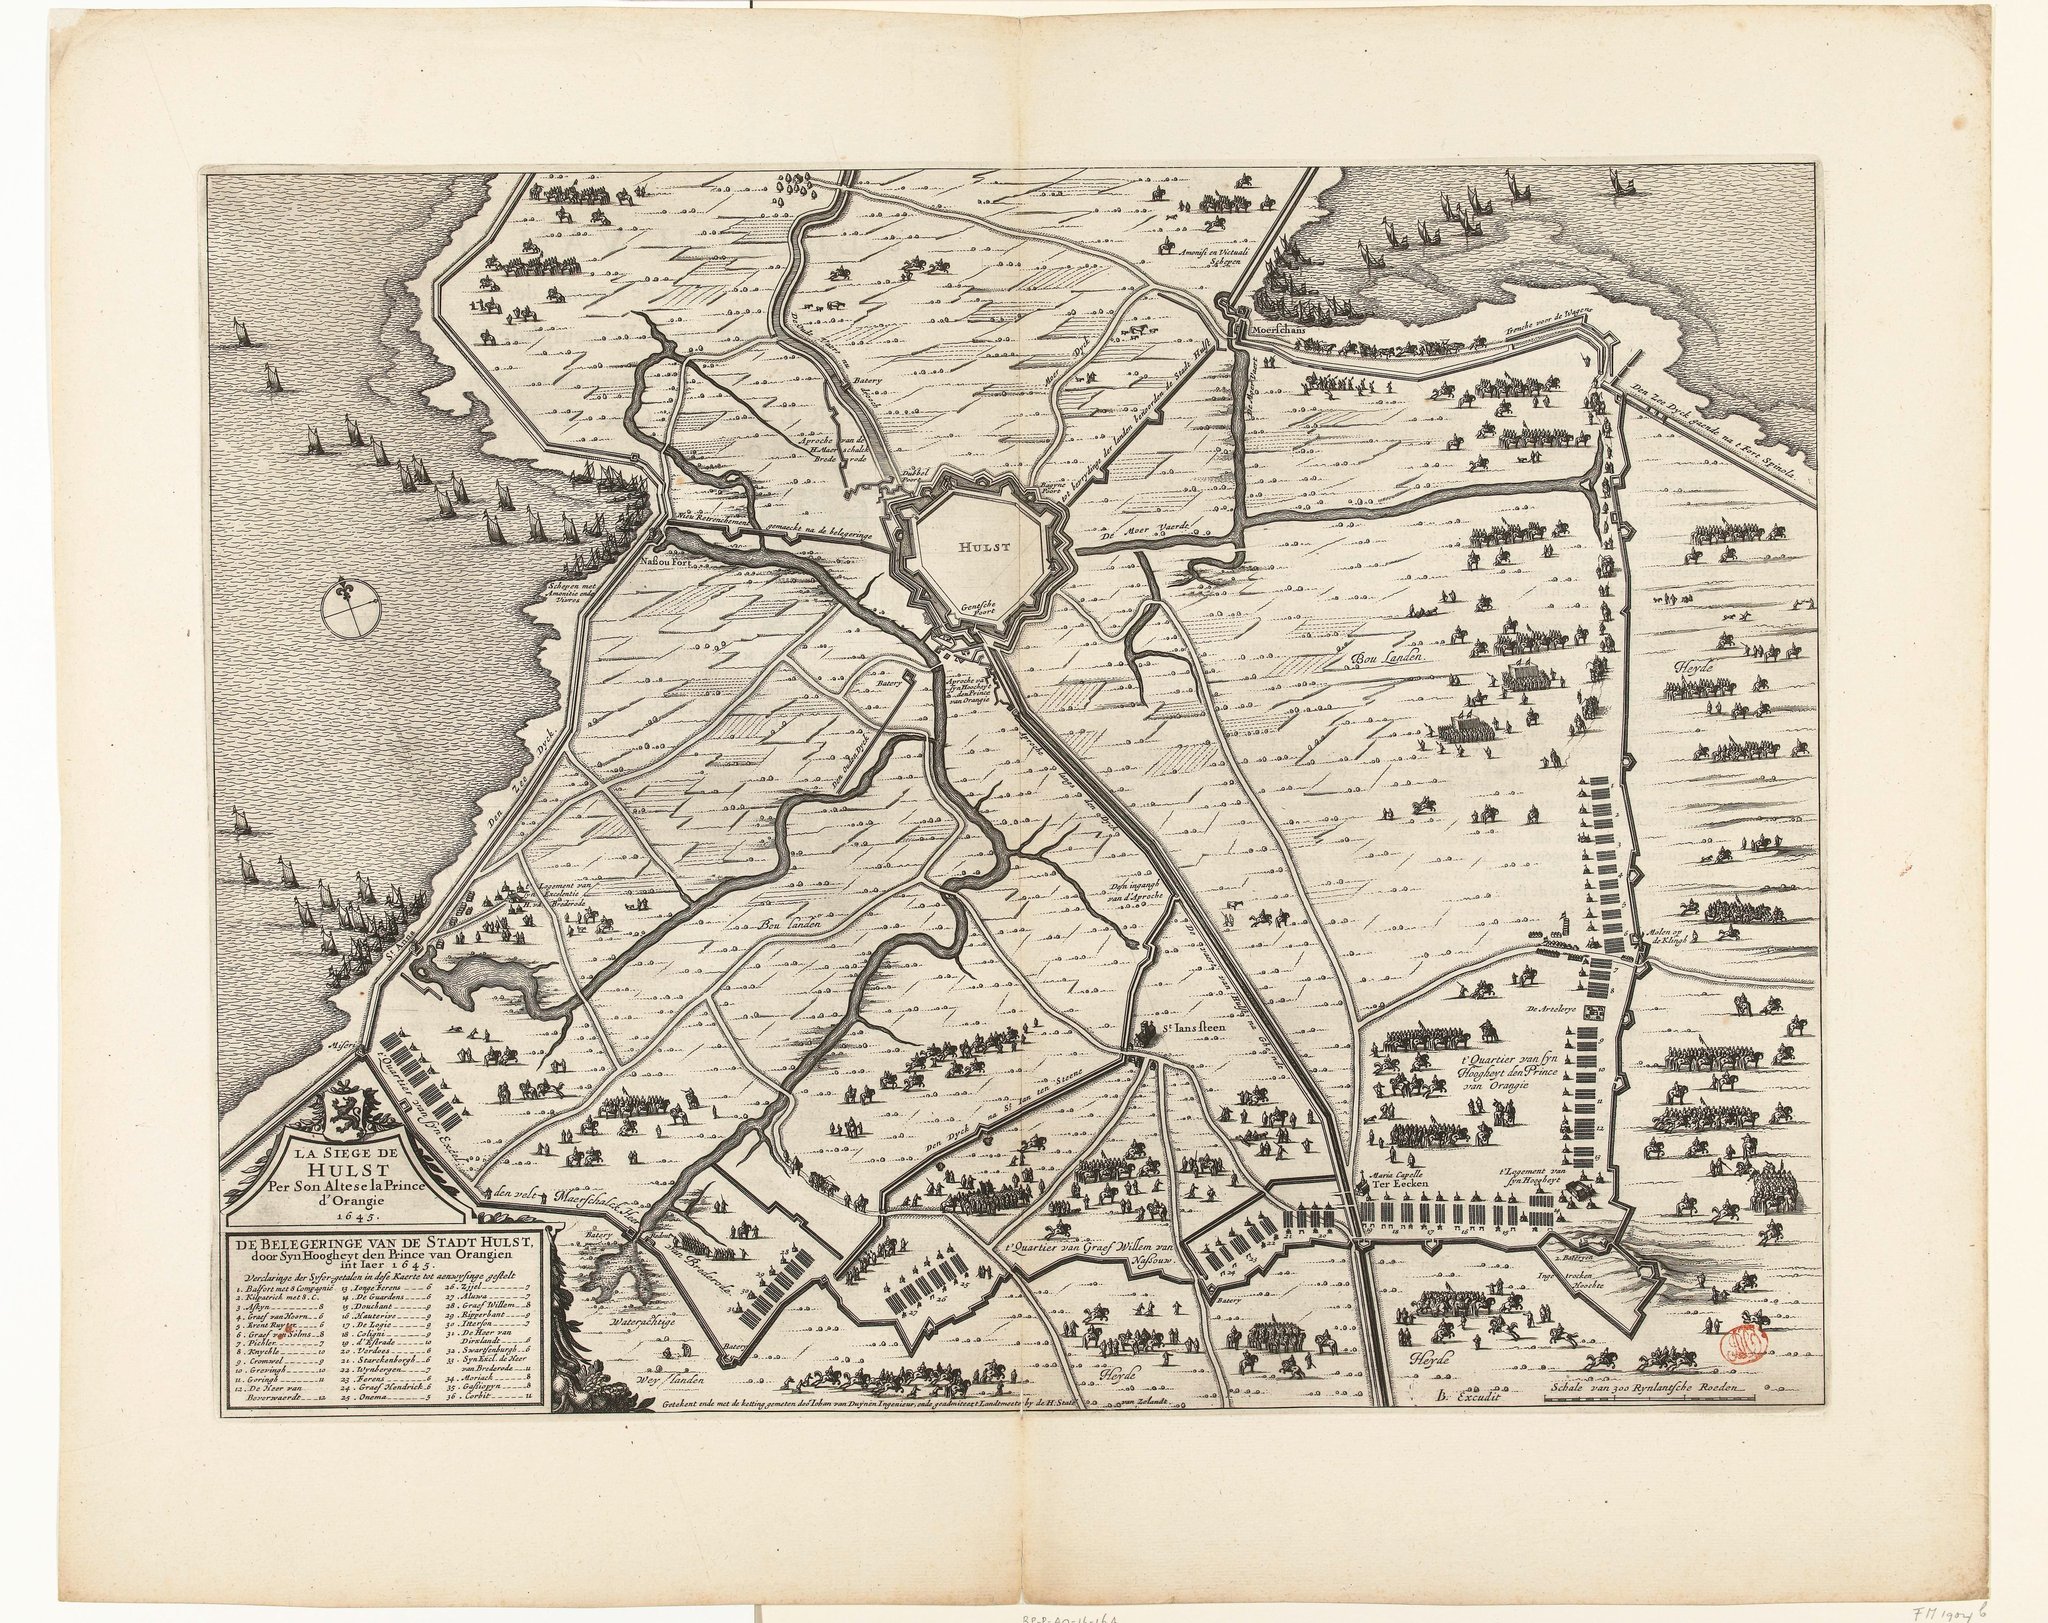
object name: print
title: Beleg van Hulst door Frederik Hendrik, 1645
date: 1645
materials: paper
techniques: engraving, etching, letterpress printing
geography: northern netherlands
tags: delft, frederick henry (prince of orange), maps of separate countries or regions, siege, position war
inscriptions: collector's mark: Lugt 195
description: Beleg en verovering van Hulst door het Staatse leger onder Frederik Hendrik van 28 september tot 5 november 1645. Plan van de stad Hulst en het omliggende land met de omsingeling en de legerkampen van de belegeraars. Linksonder een cartouche met de legenda 1-26. Rechtsonder een schaalstok: Schale van 300 Rynlantsche Roeden. Op verso Nederlandse tekst.